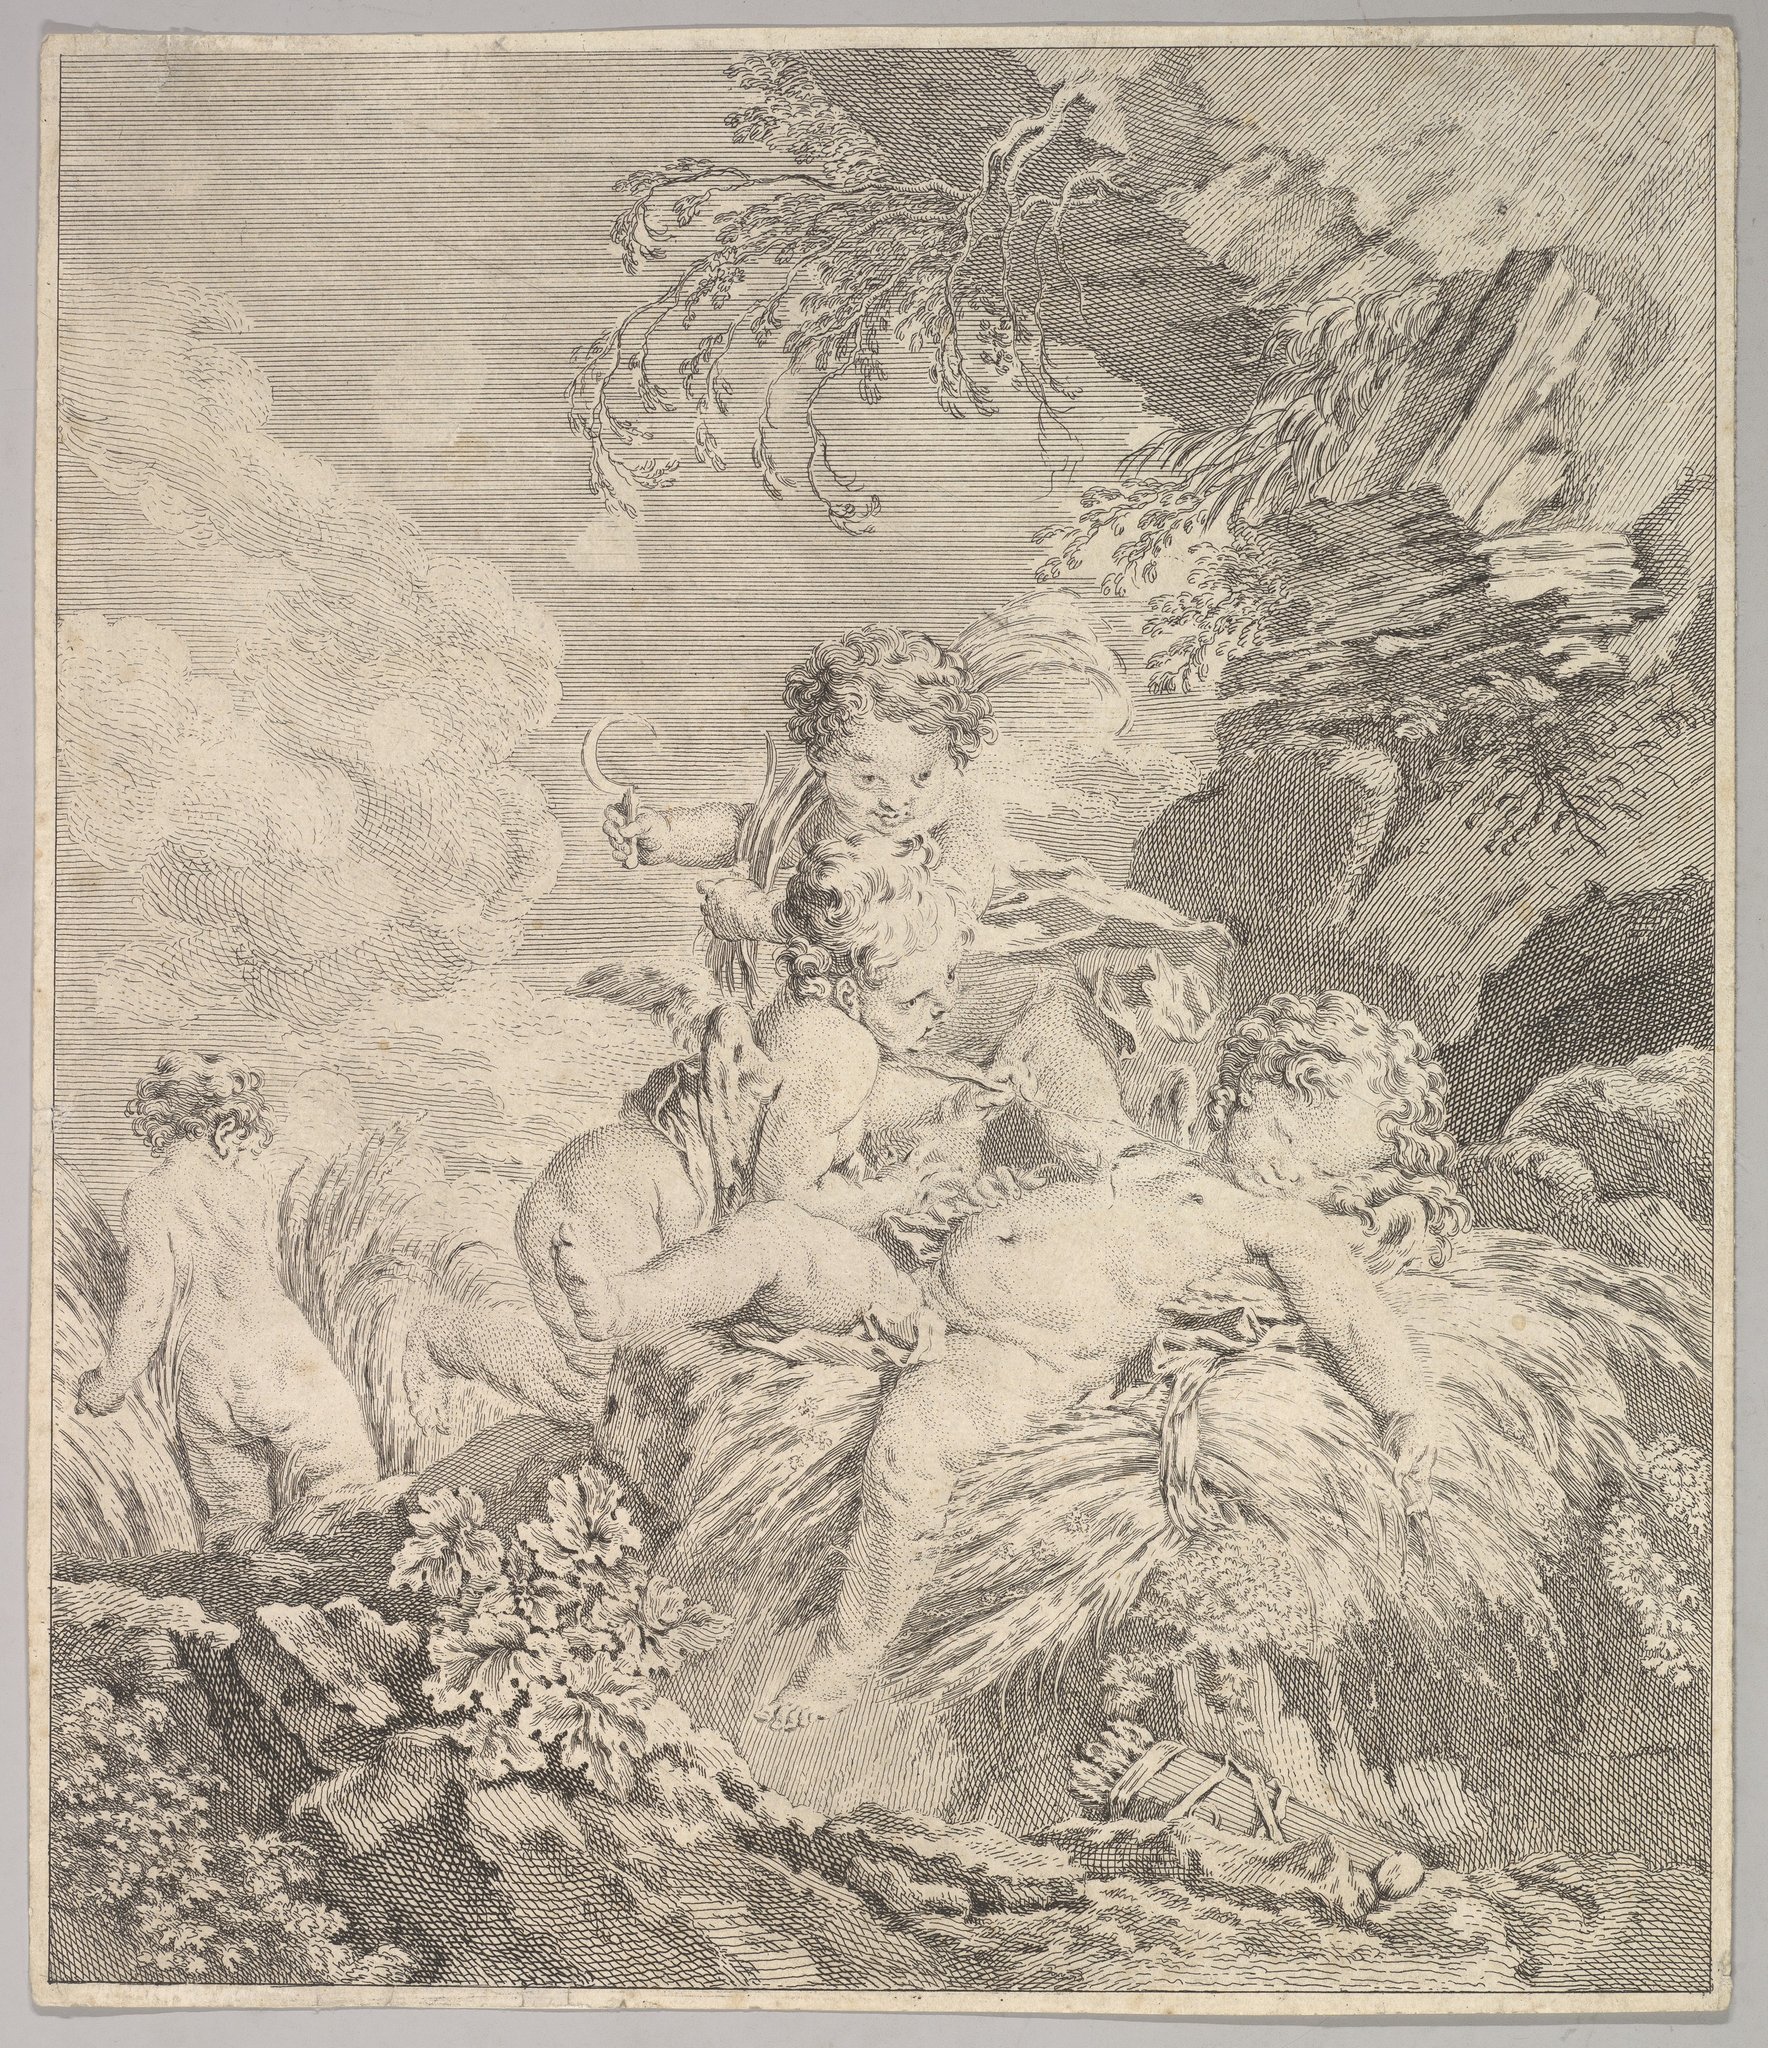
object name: print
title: Cupids Tickling Each Other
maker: anonymous, french, 18th century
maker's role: artist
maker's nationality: french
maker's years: 1700-1800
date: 1701-1800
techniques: etching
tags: cupid